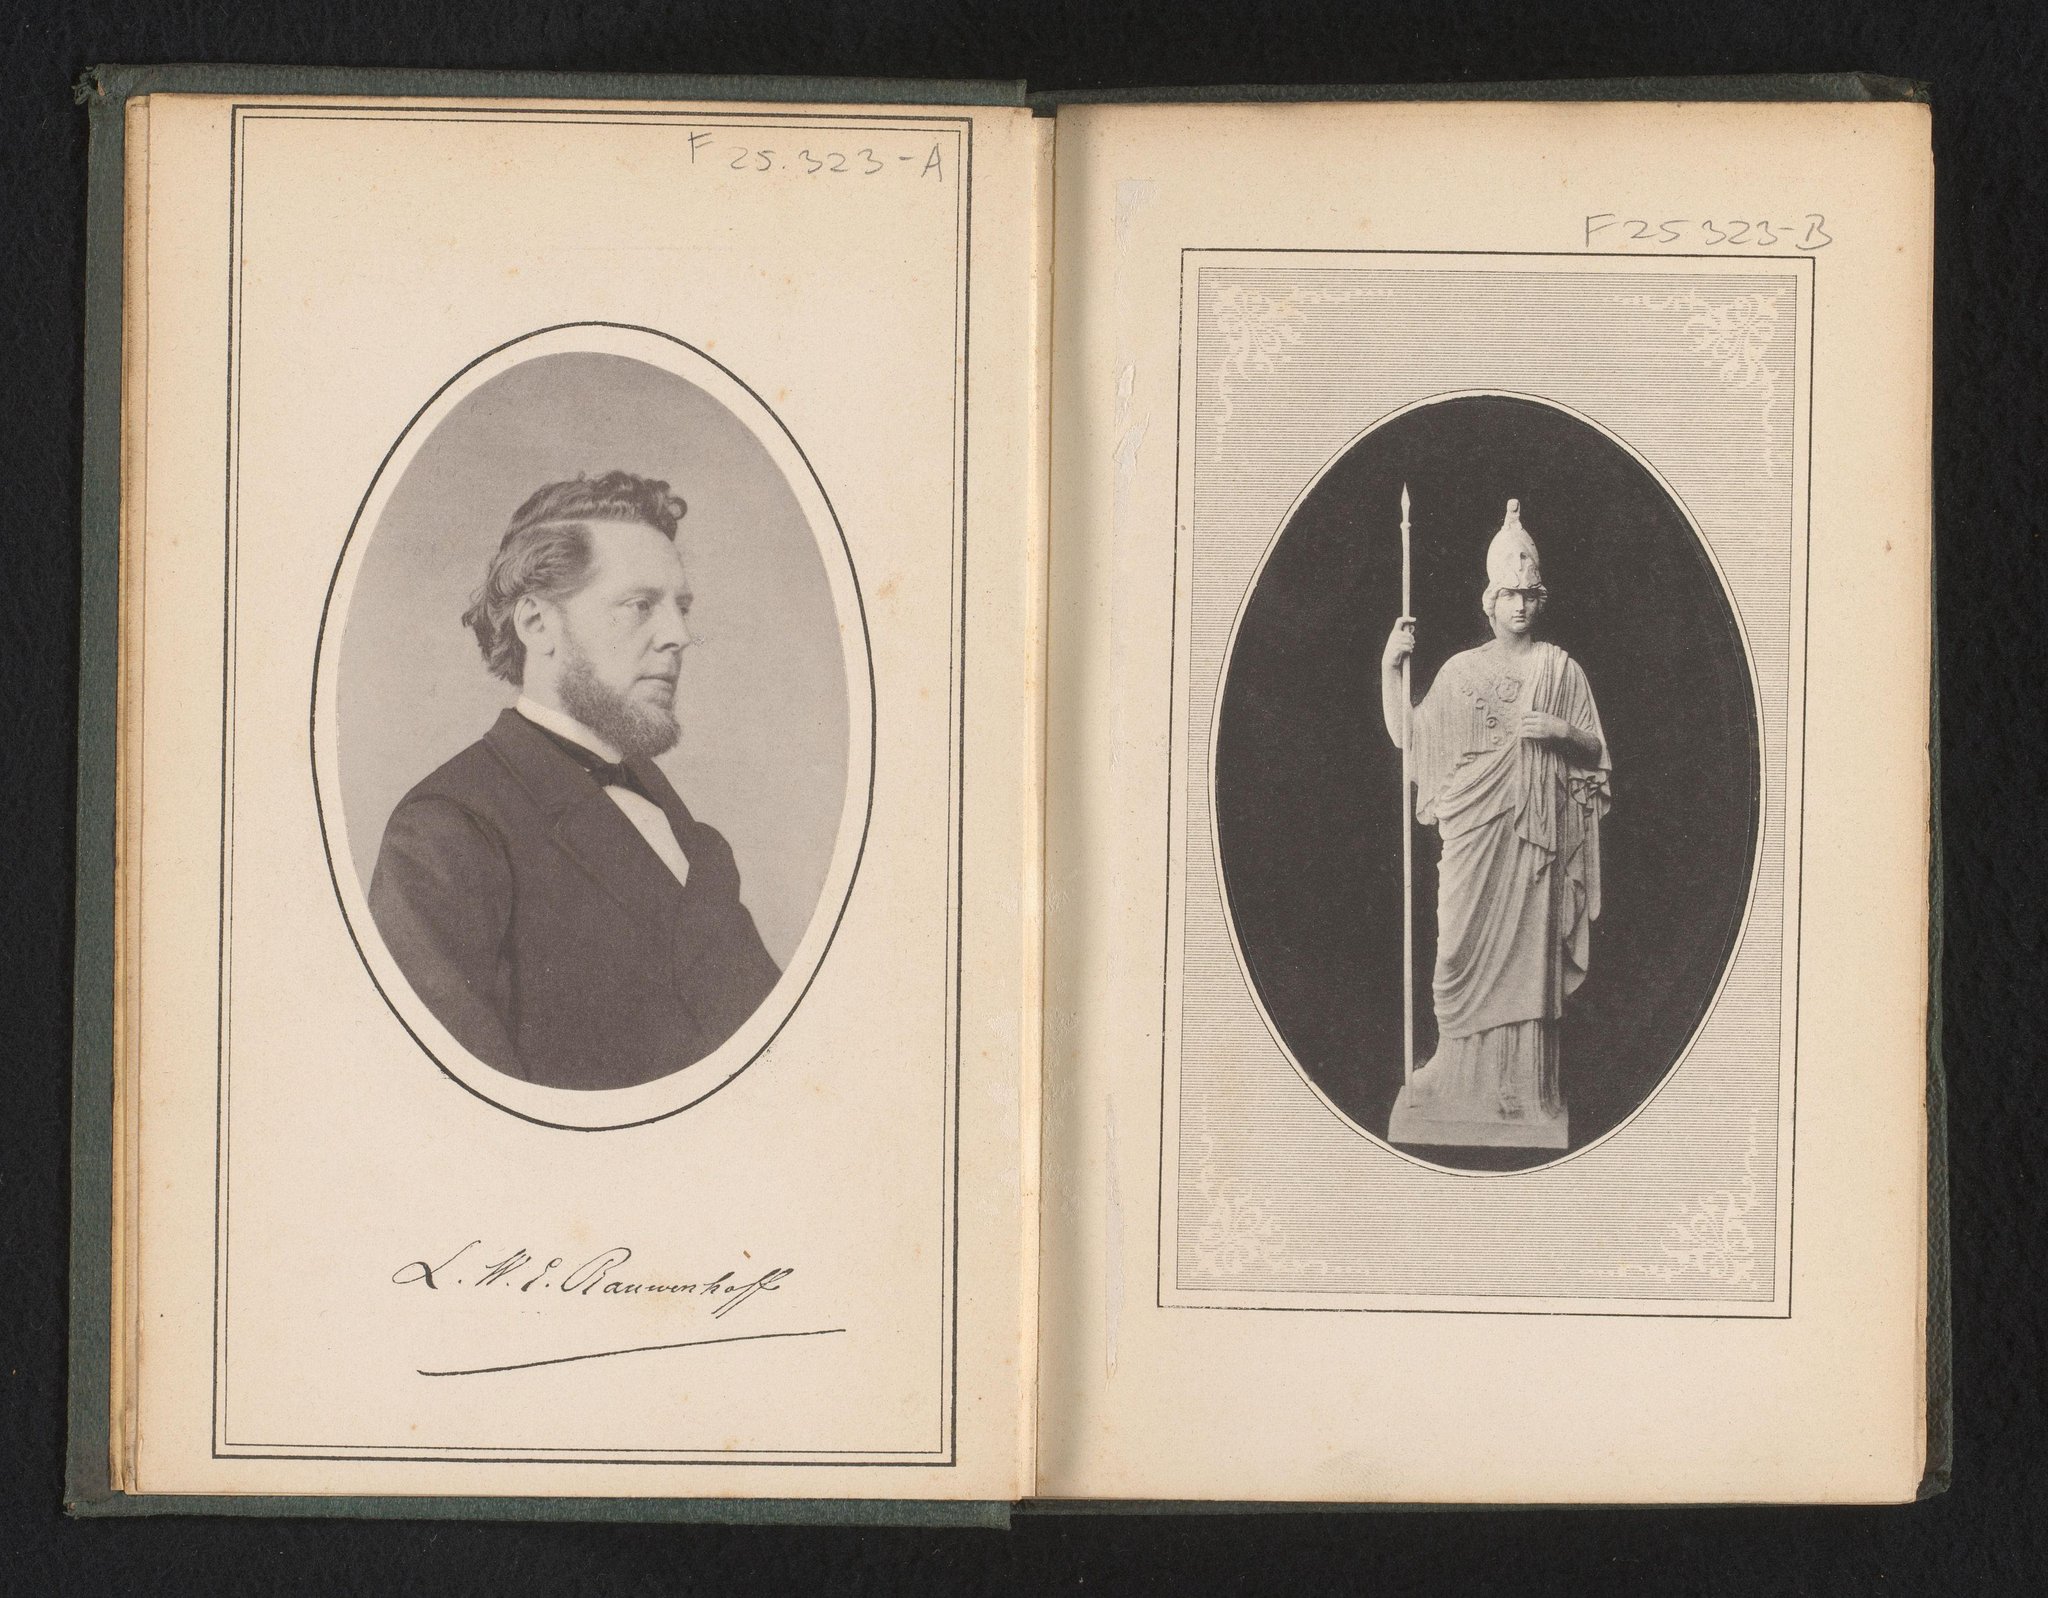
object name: page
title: Portret van L.W.E. Rauwenhoff, hoogleraar godgeleerdheid en Rector Magnificus van de Universiteit Leiden 1871-1872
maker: Anonymous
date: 1870-1871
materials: paper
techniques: photolithography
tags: historical persons, professor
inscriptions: signature: ‘L.W.E. Rauwenhoff’